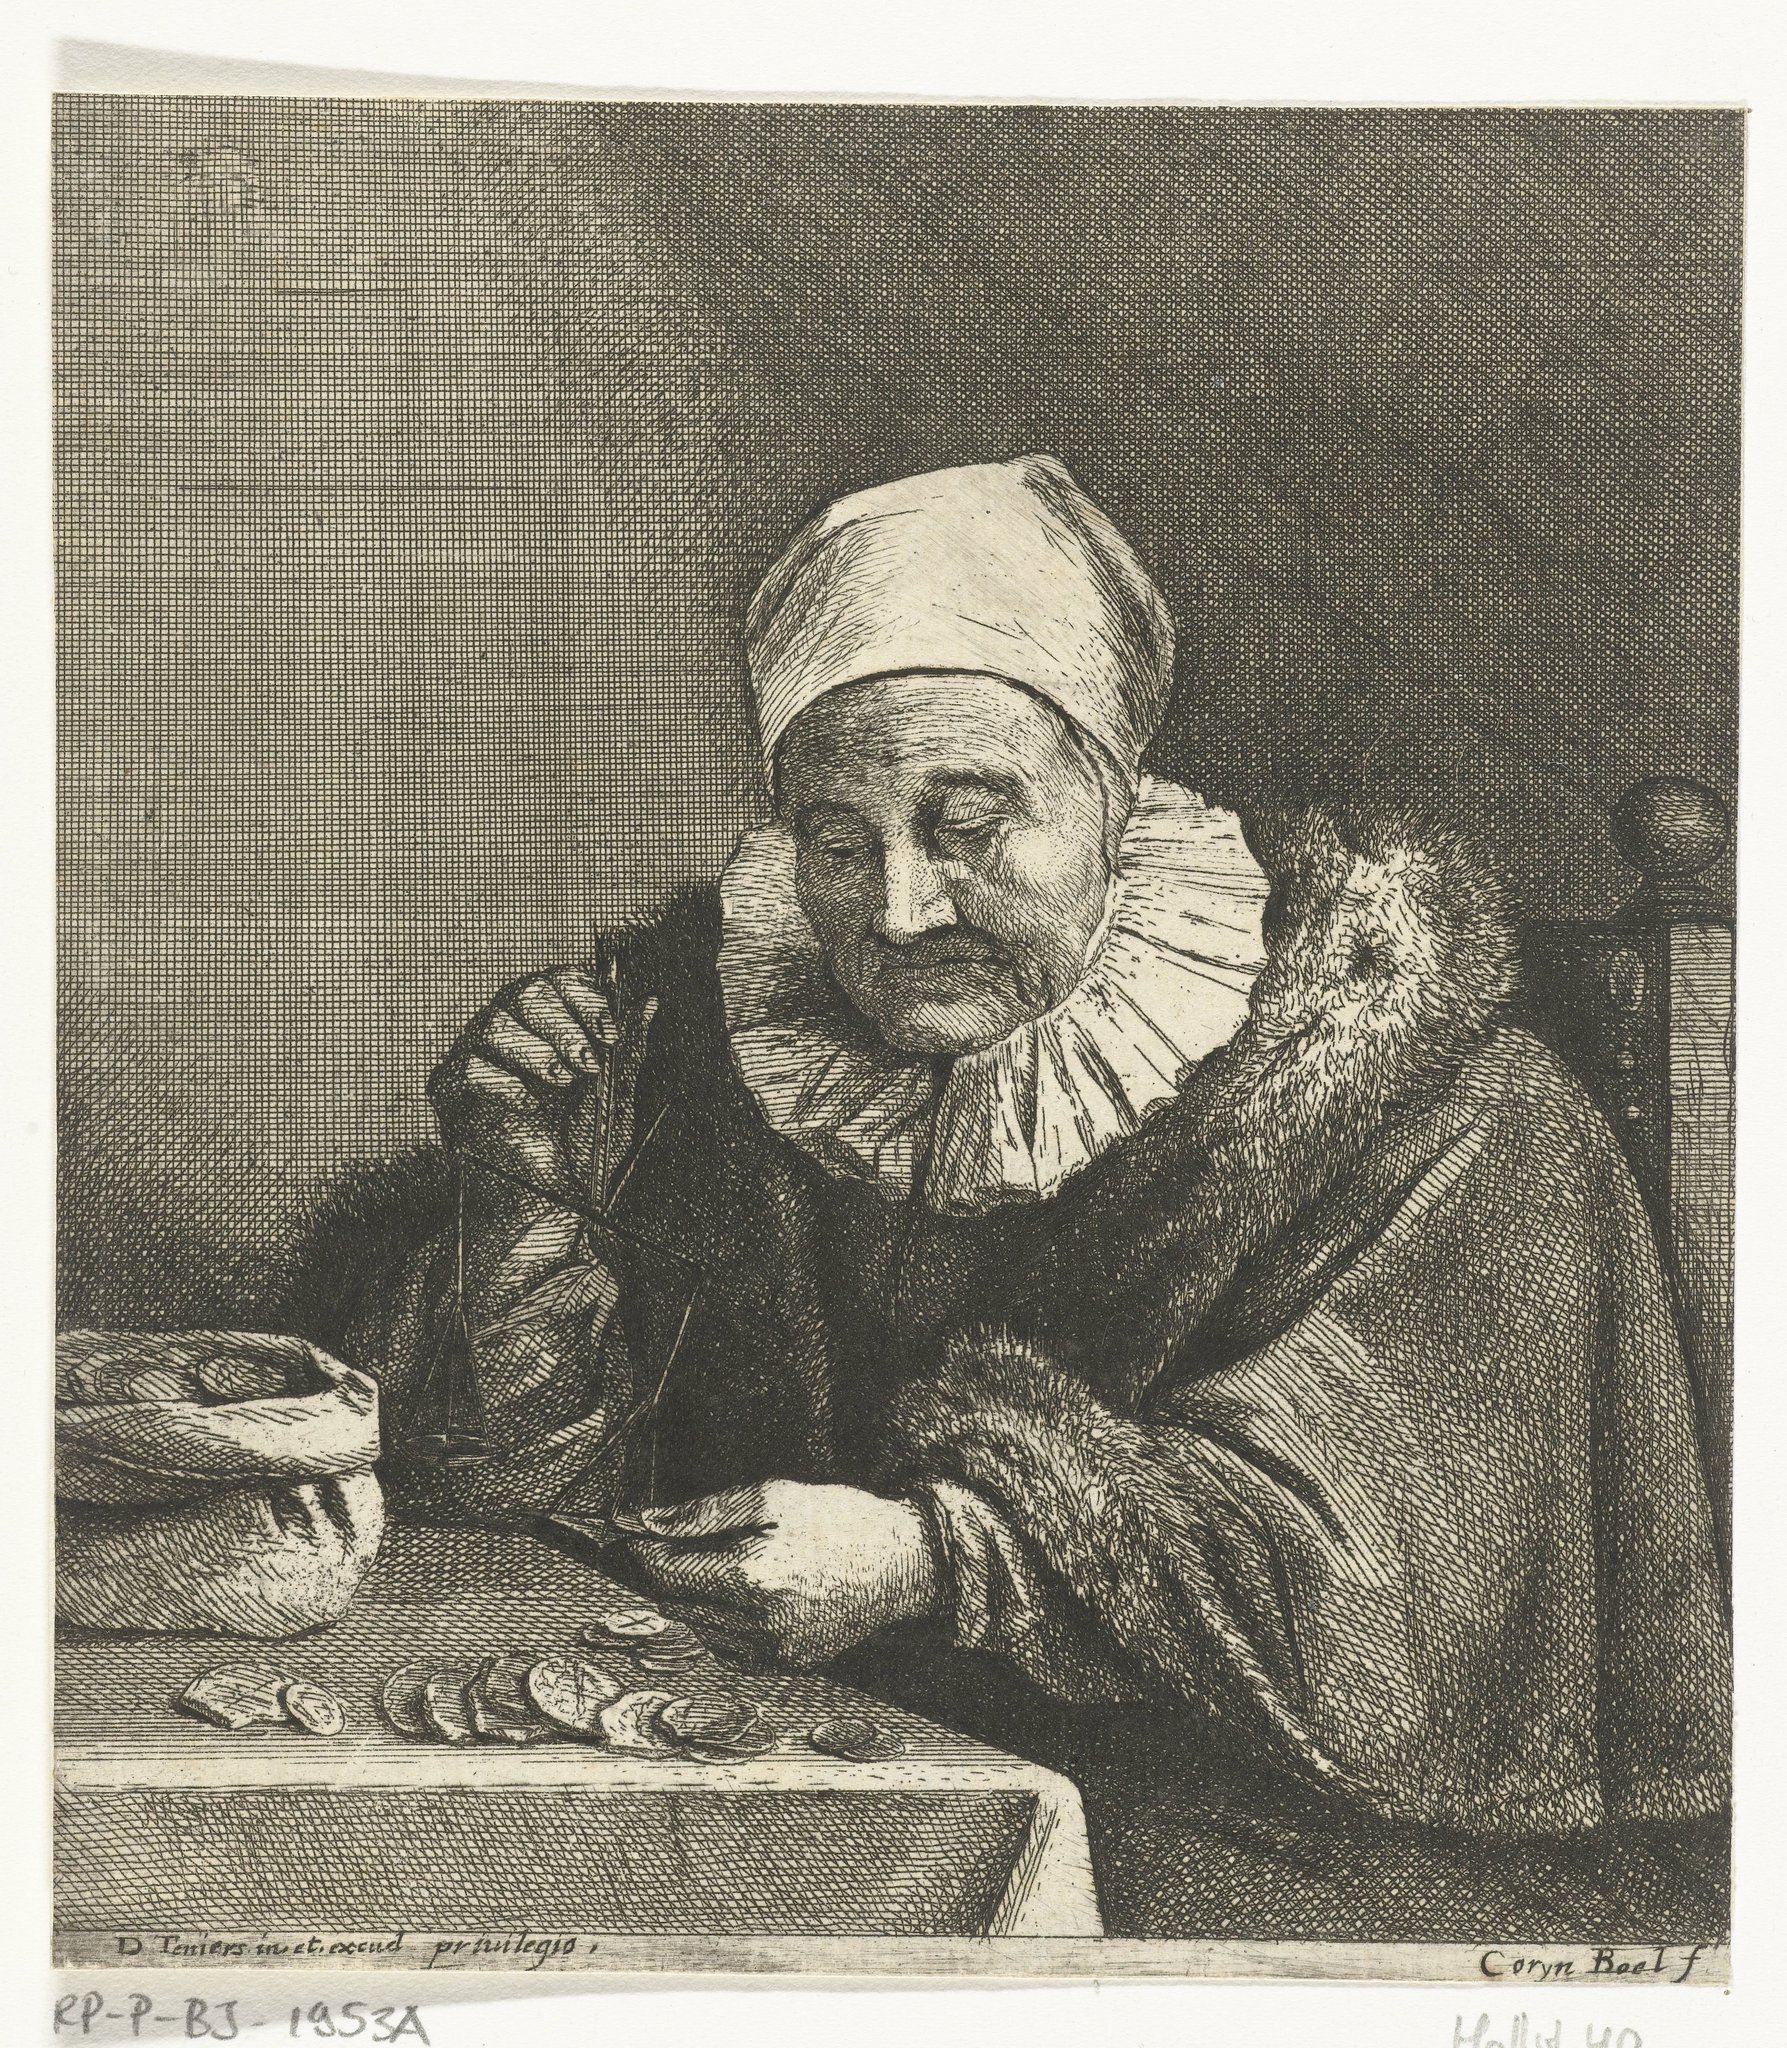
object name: print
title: Goudweegster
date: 1635-1668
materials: paper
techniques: etching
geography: southern netherlands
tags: weighing gold or money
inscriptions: collector's mark: Lugt 2228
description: Een oude vrouw zit aan tafel met een weegschaal in haar hand. Op tafel liggen gouden munten.